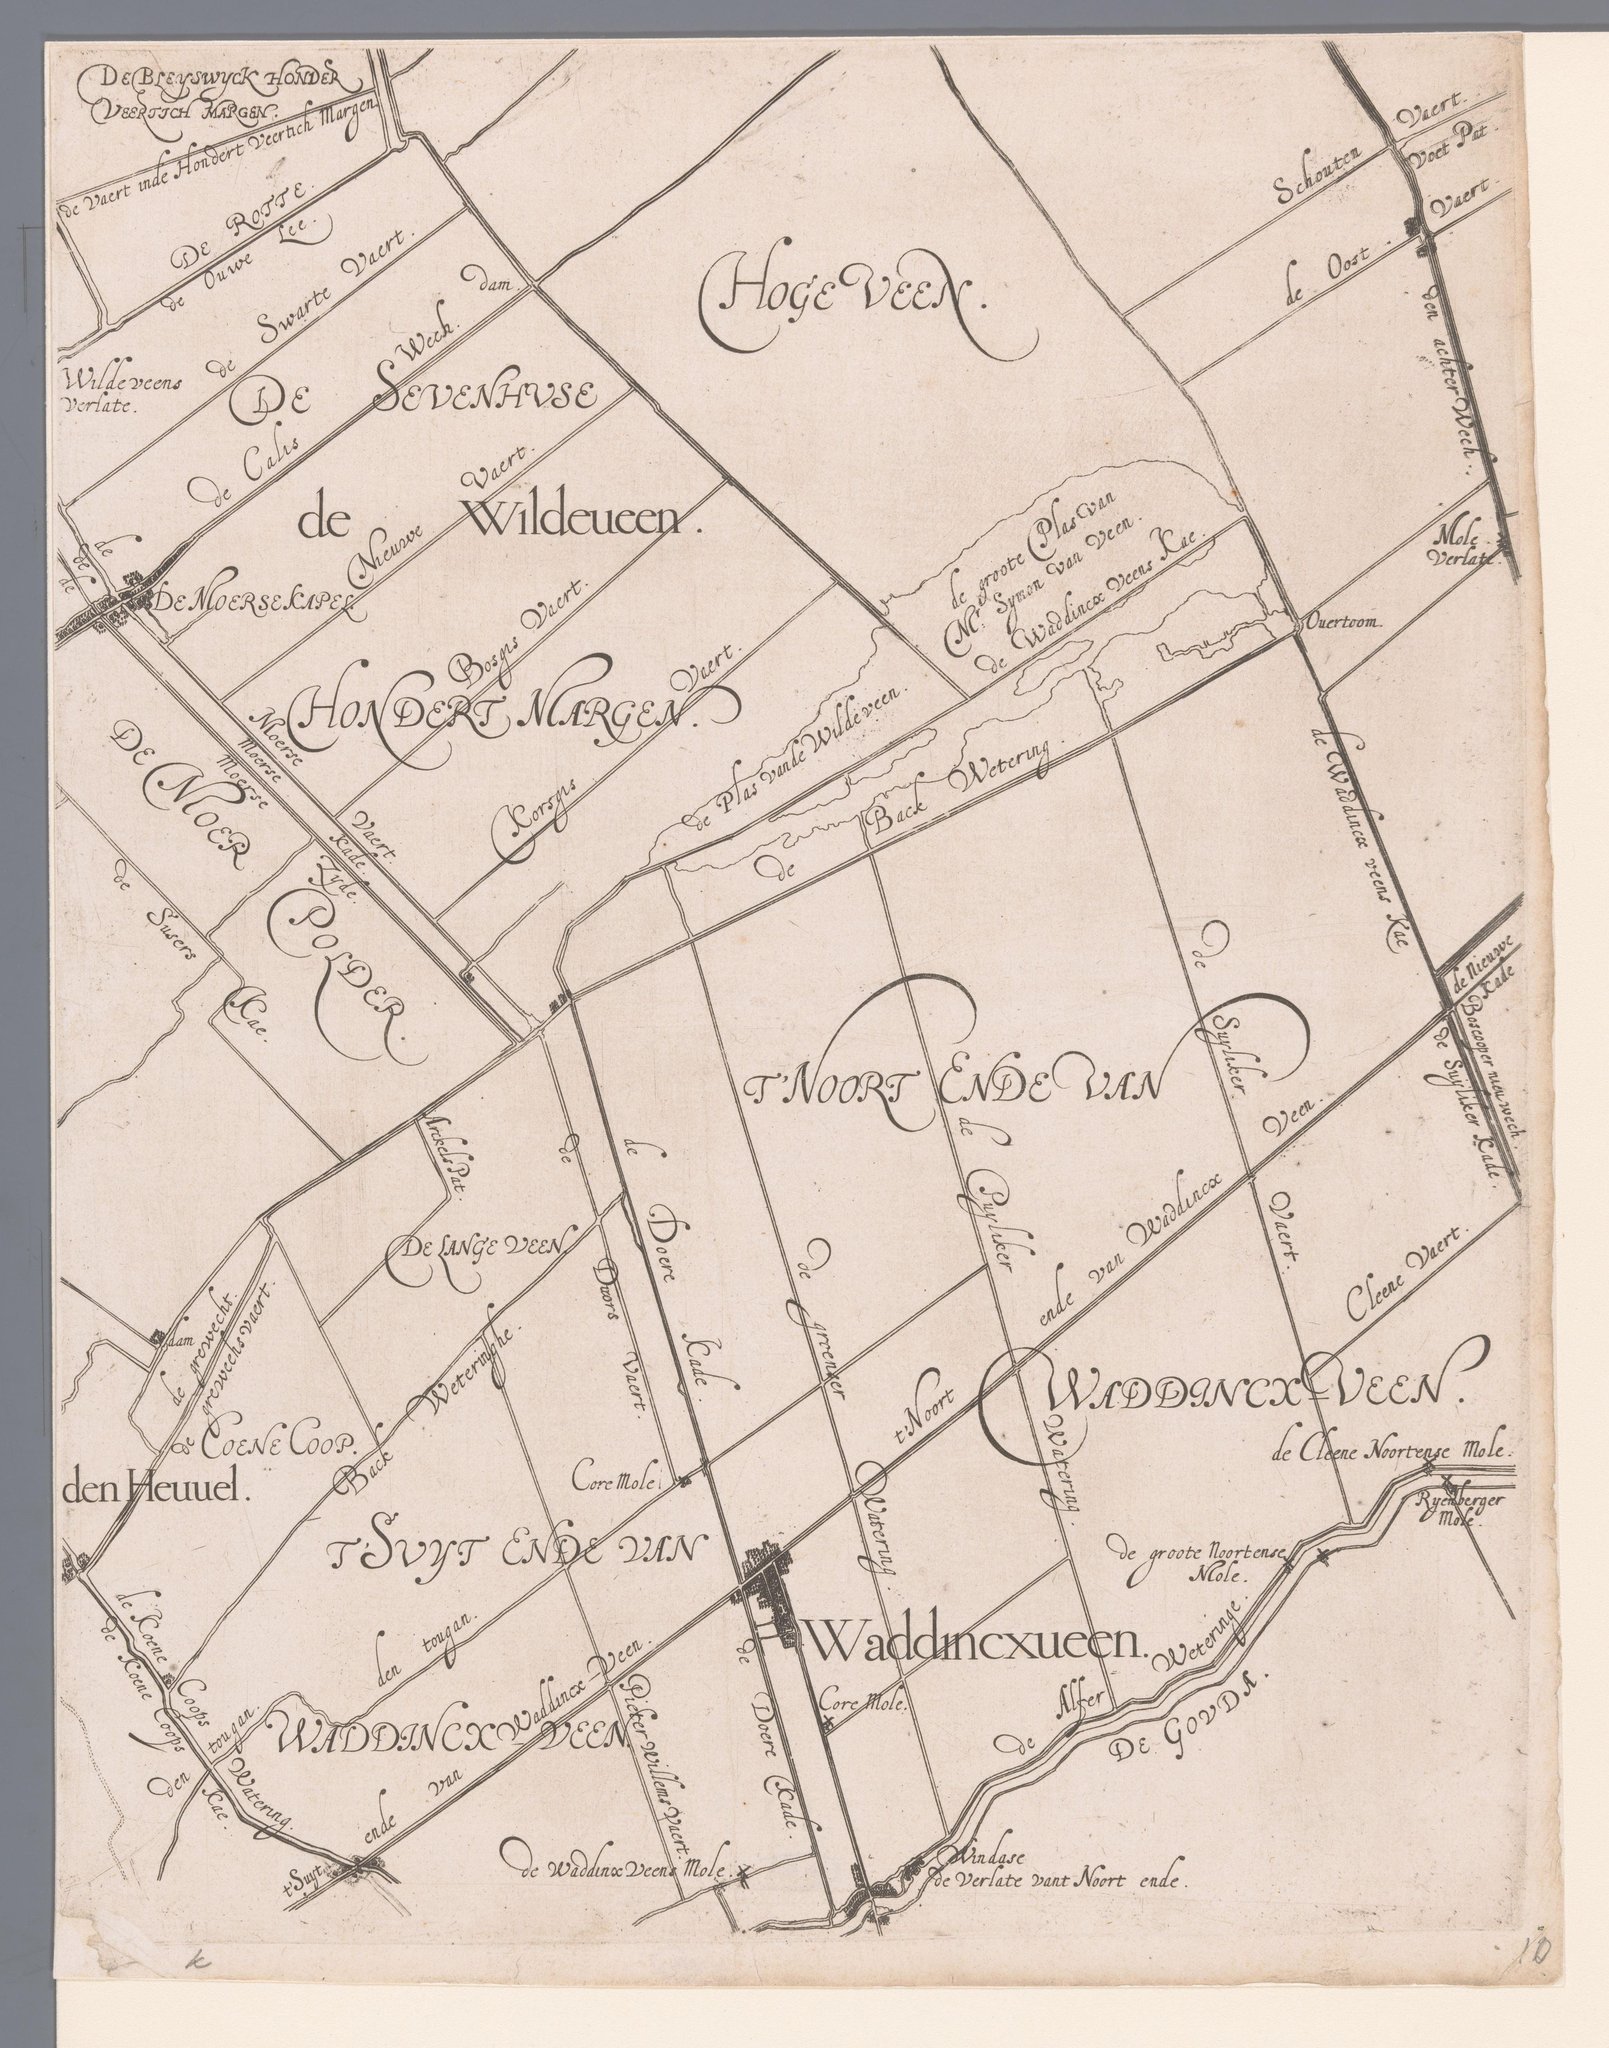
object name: print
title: Kaart van het Hoogheemraadschap van Schieland, met Waddinxveen en Moerkapelle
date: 1611-1635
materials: paper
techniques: engraving, etching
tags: maps of separate countries or regions, armorial bearing, heraldry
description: Deze kaart is tussen 1611 en 1635 vijf keer uitgegeven zonder dat de platen zijn bijgewerkt. Onduidelijk tot welke uitgave dit exemplaar behoort.